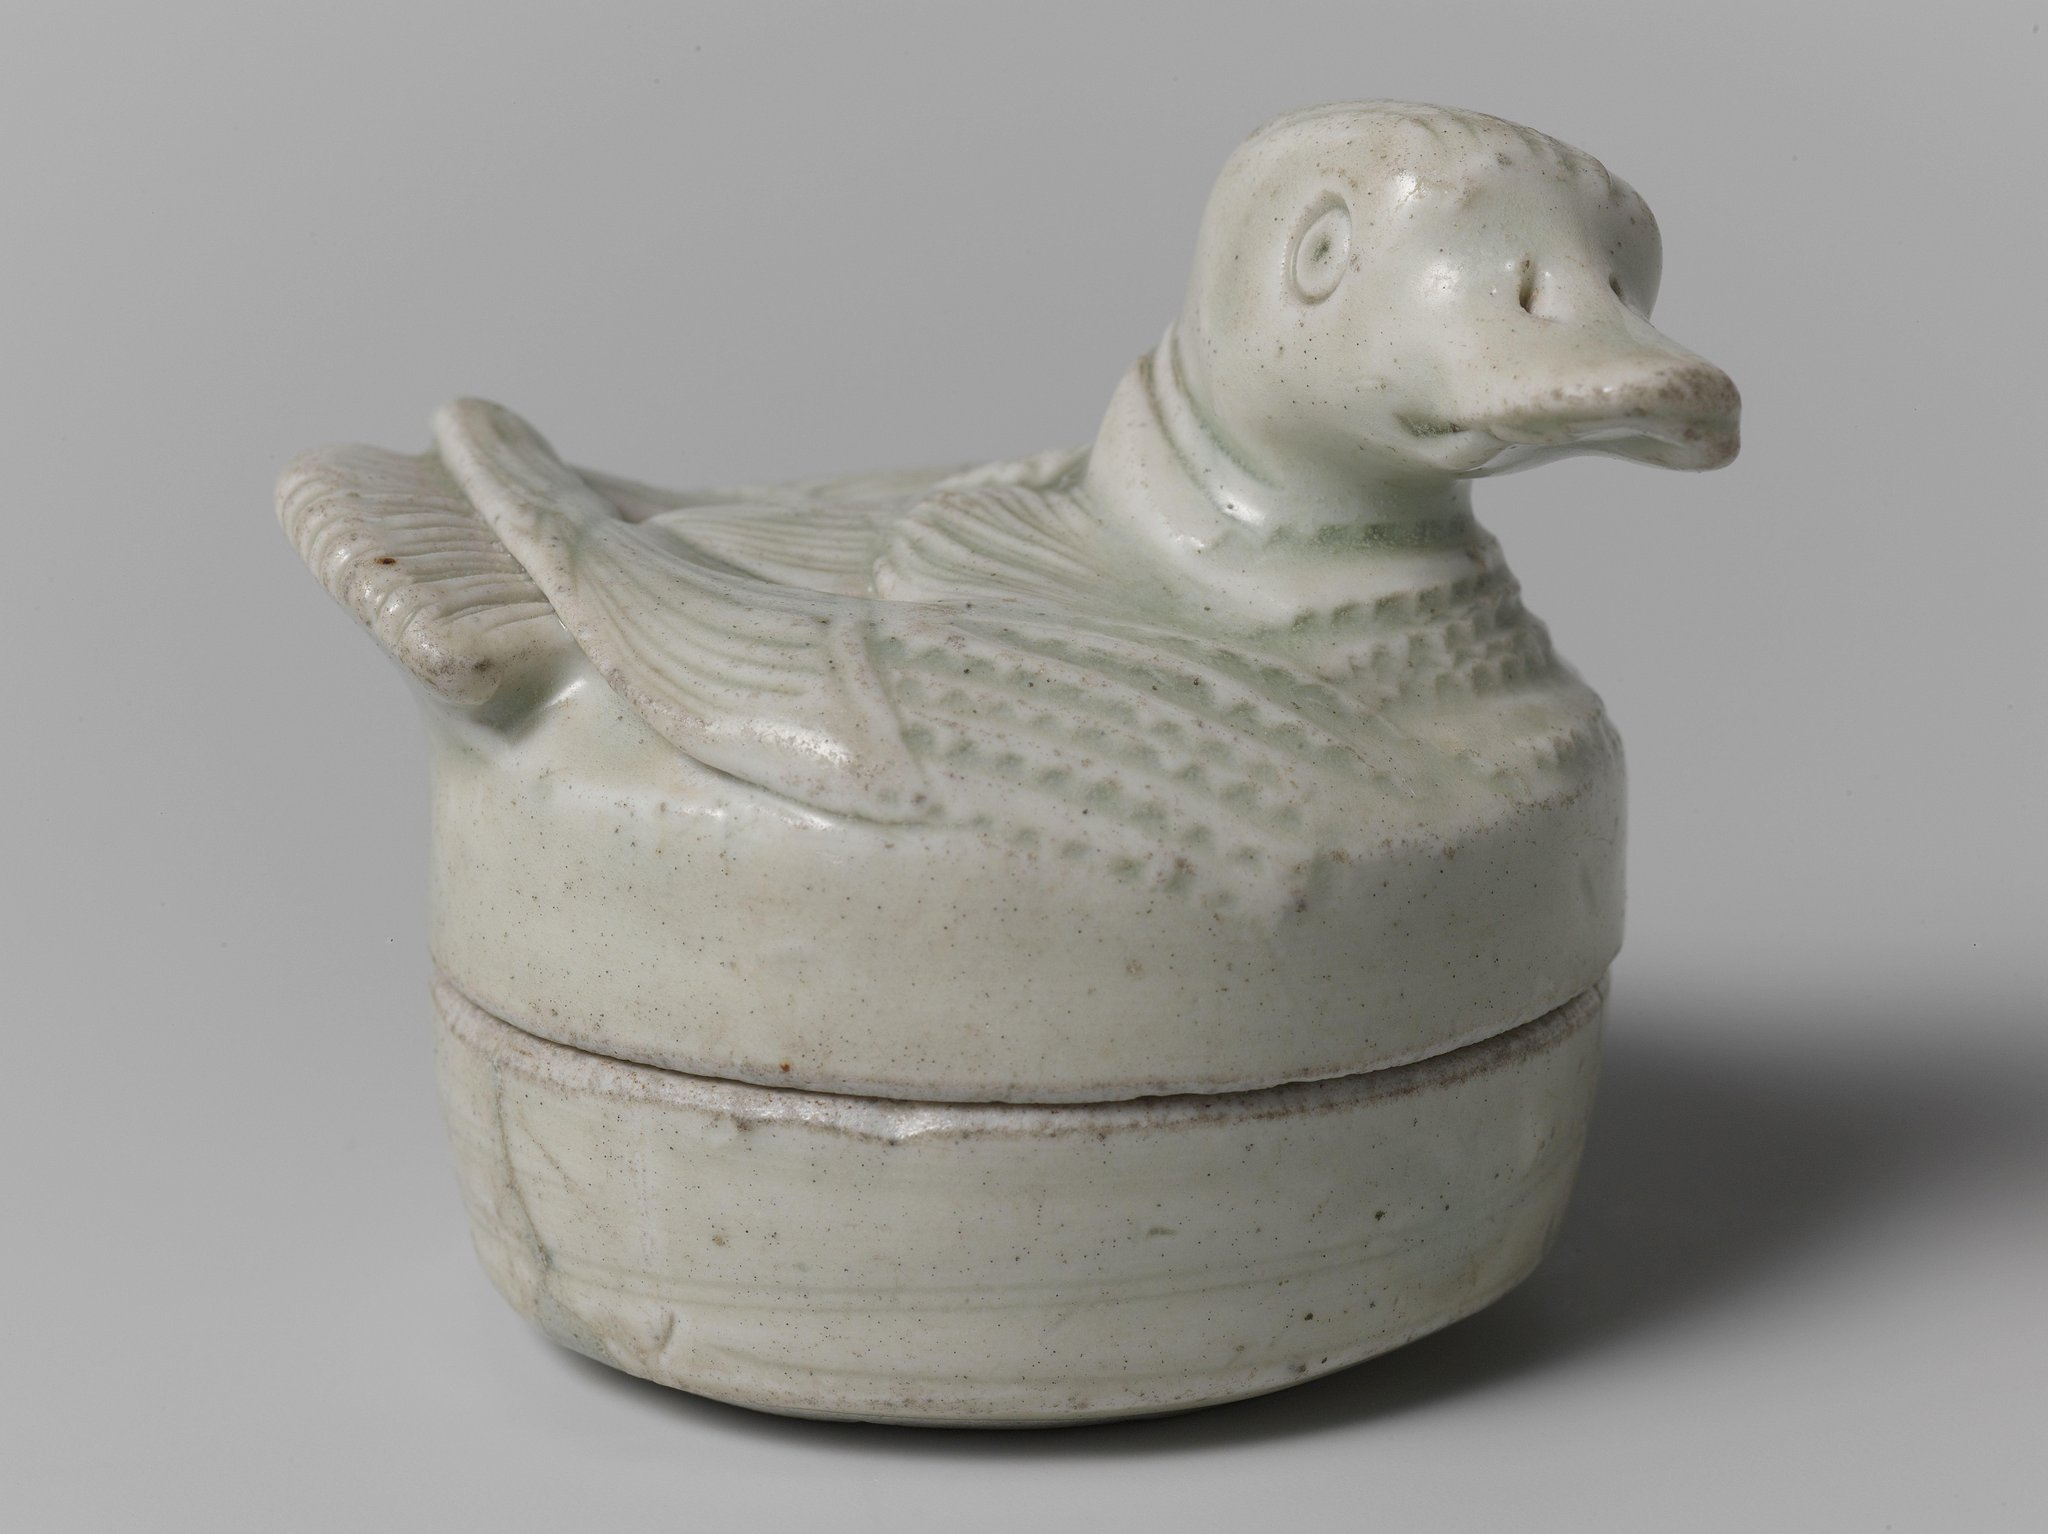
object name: box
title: Container in the form of a bird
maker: Anonymous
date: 960-1279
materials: glaze, porcelain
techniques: firing, forming, turning, vitrification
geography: china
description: Ronde doos van steengoed, bedekt met een transparant glazuur met een lichtblauwe tint. Qingbai.